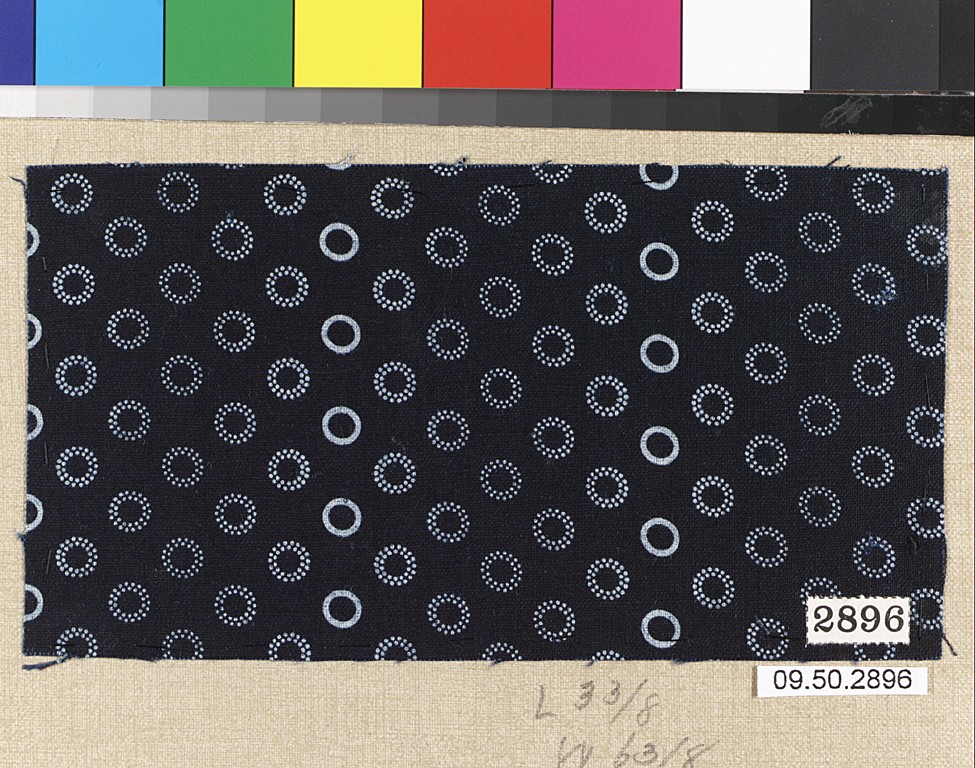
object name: piece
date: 1801-1900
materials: cotton